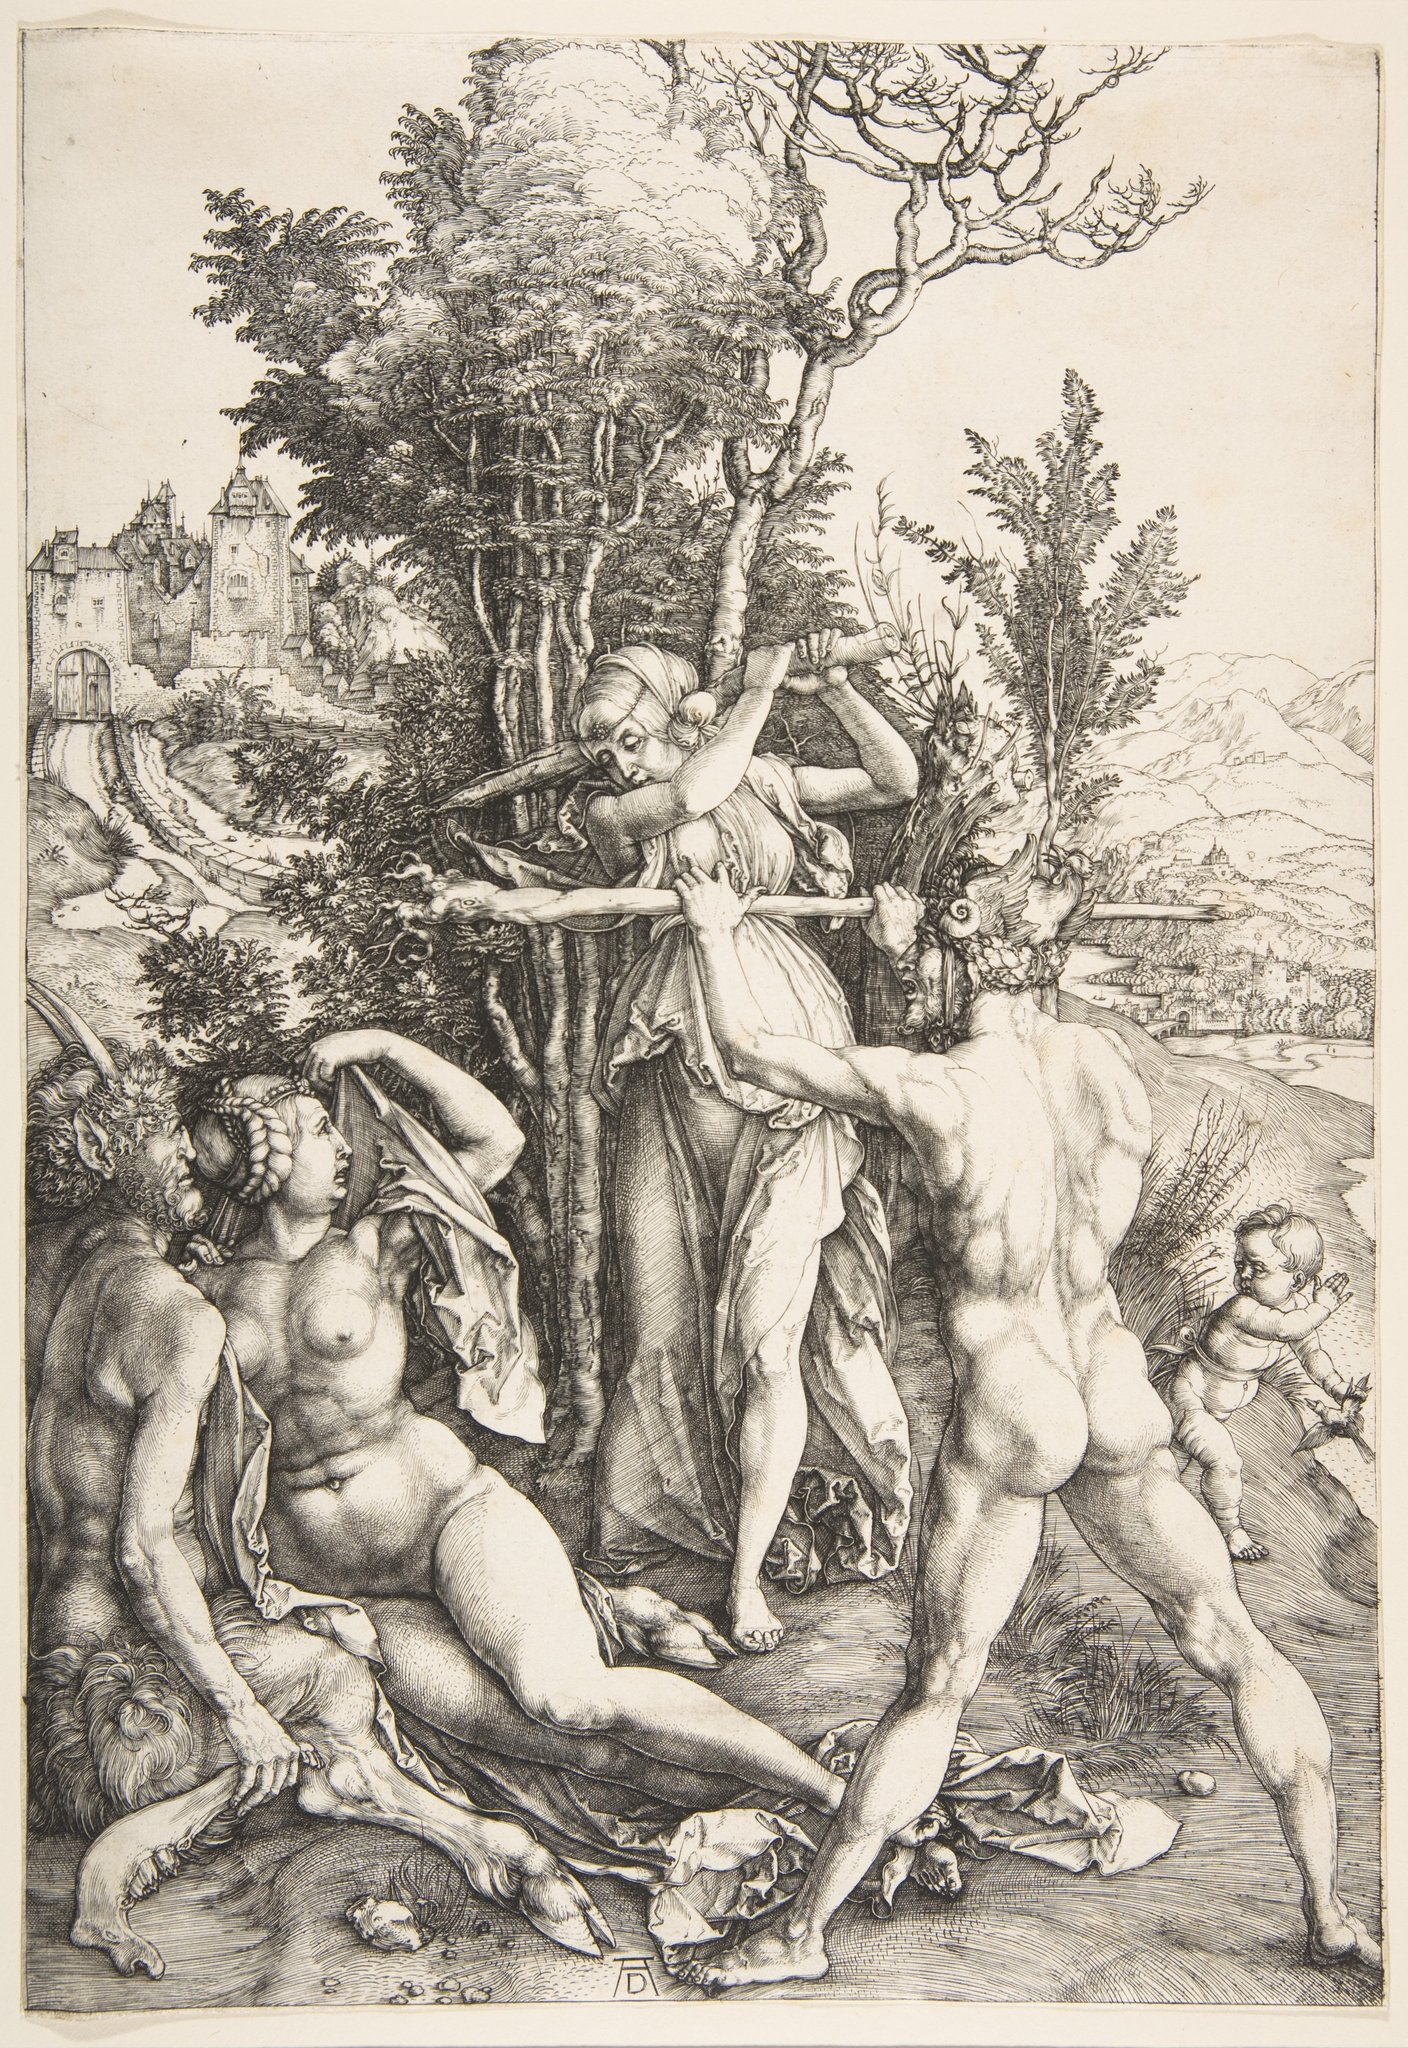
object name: print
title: Hercules at the Crossroad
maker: albrecht dürer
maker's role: artist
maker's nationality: german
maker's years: 1471-1528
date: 1498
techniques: engraving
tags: buildings,male nudes,female nudes,hercules,trees